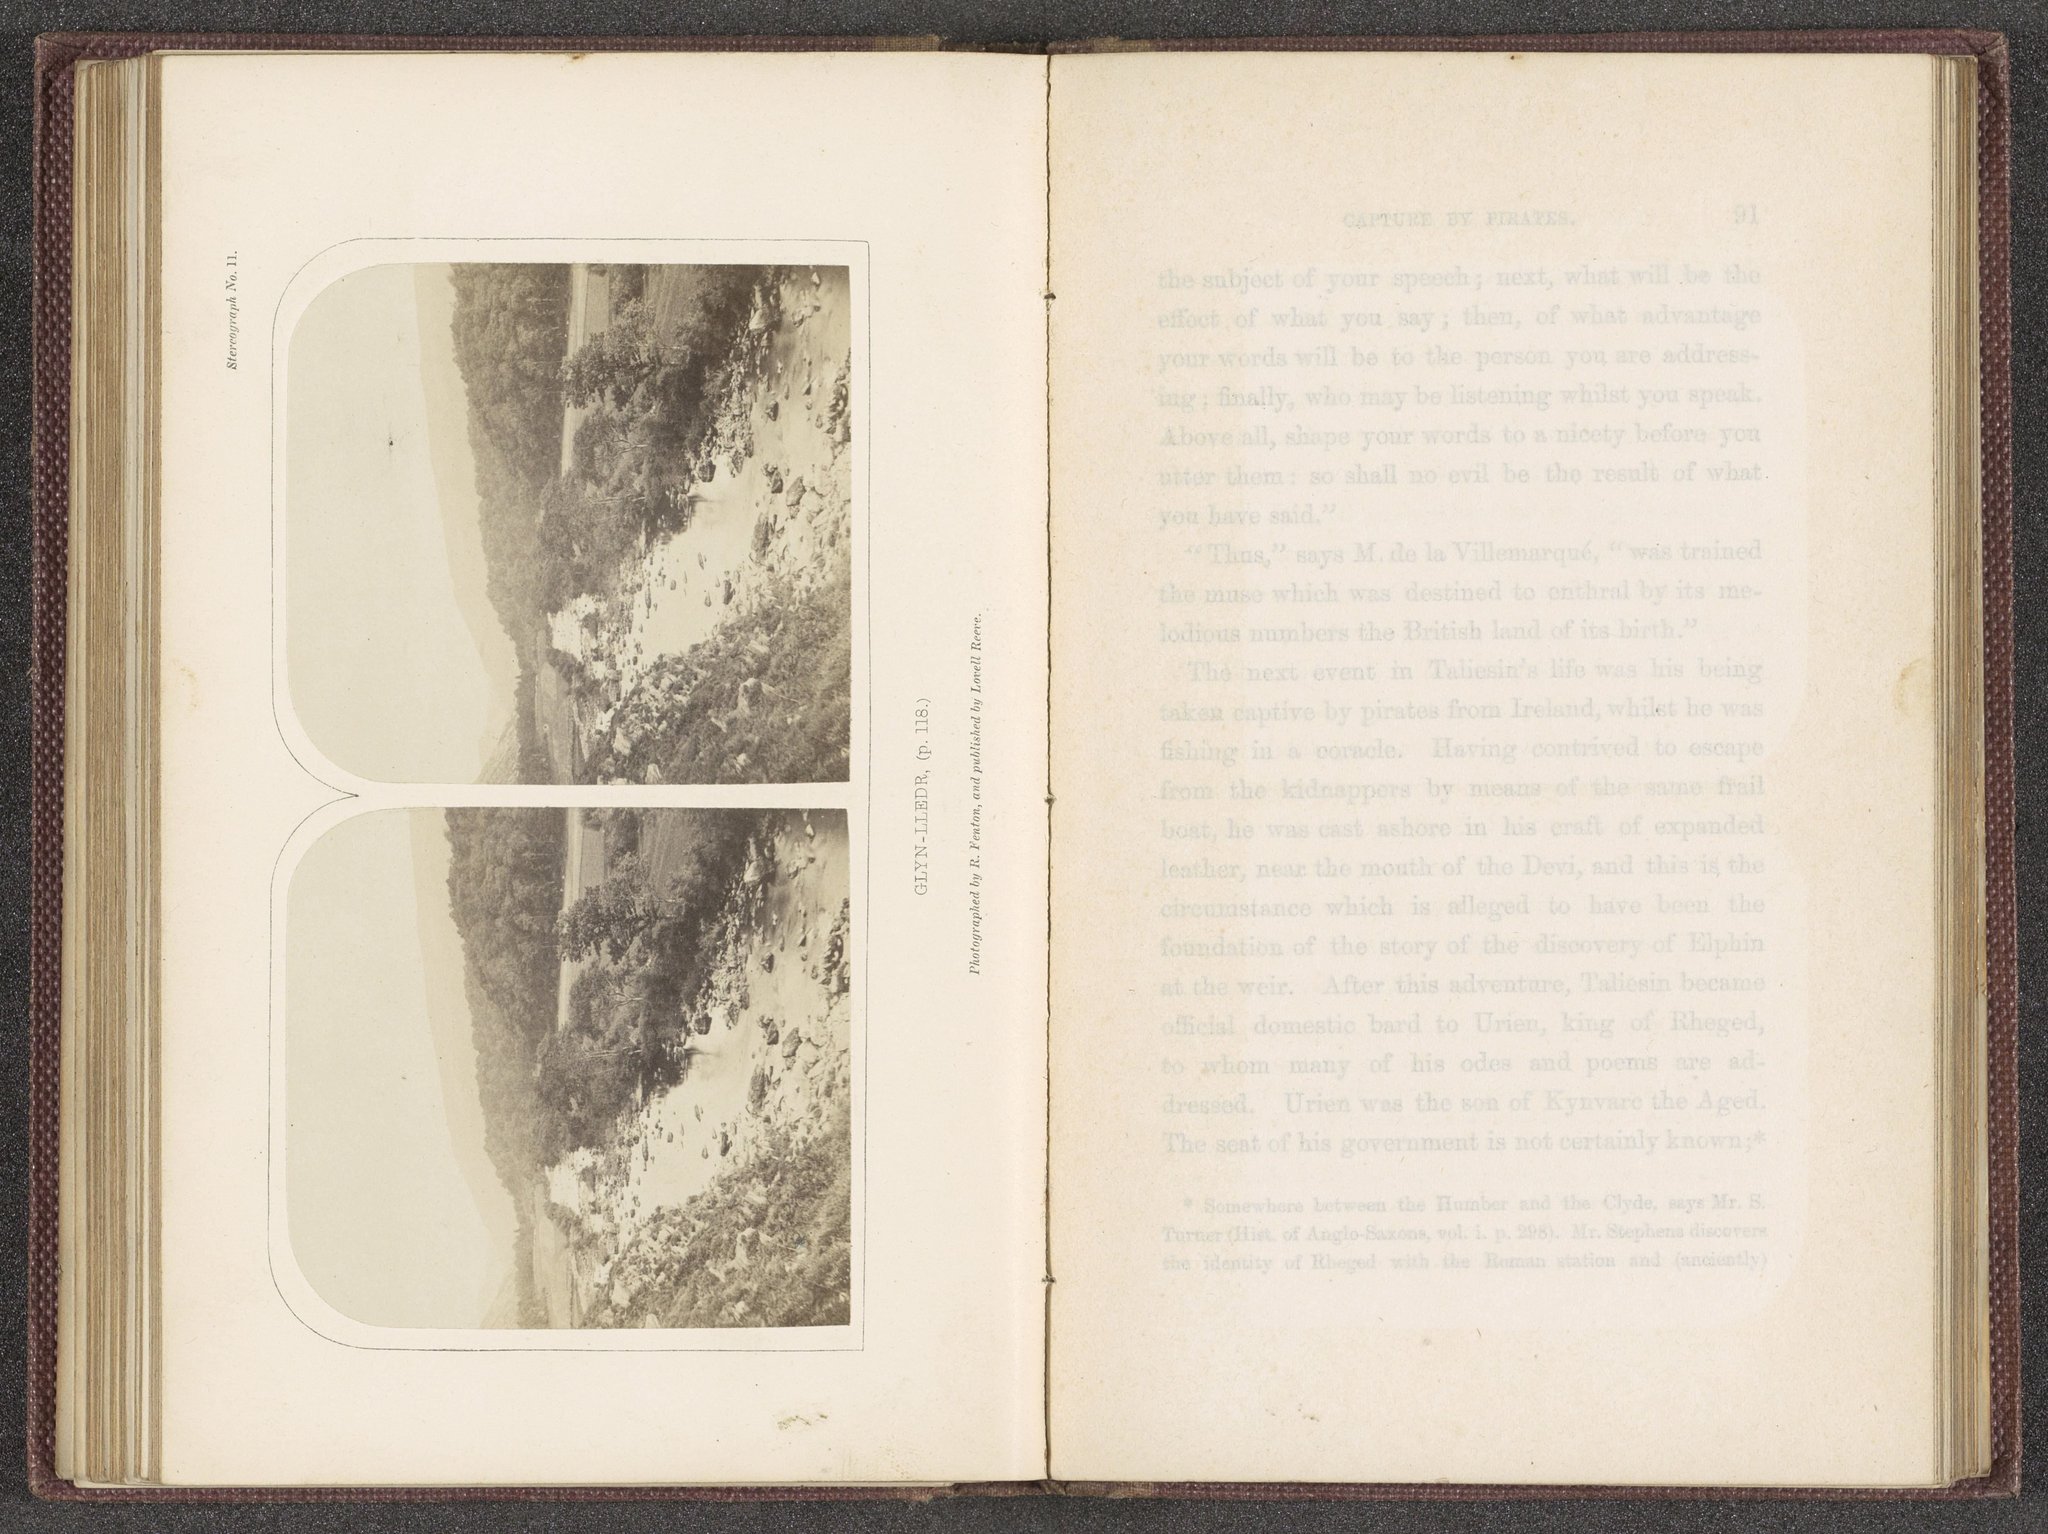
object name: stereograph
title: Glyn-Lledr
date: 1859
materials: paper, photographic support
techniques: albumen print, printing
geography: wales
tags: dale, valley, river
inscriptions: number: ‘Stereograph No. 11.’